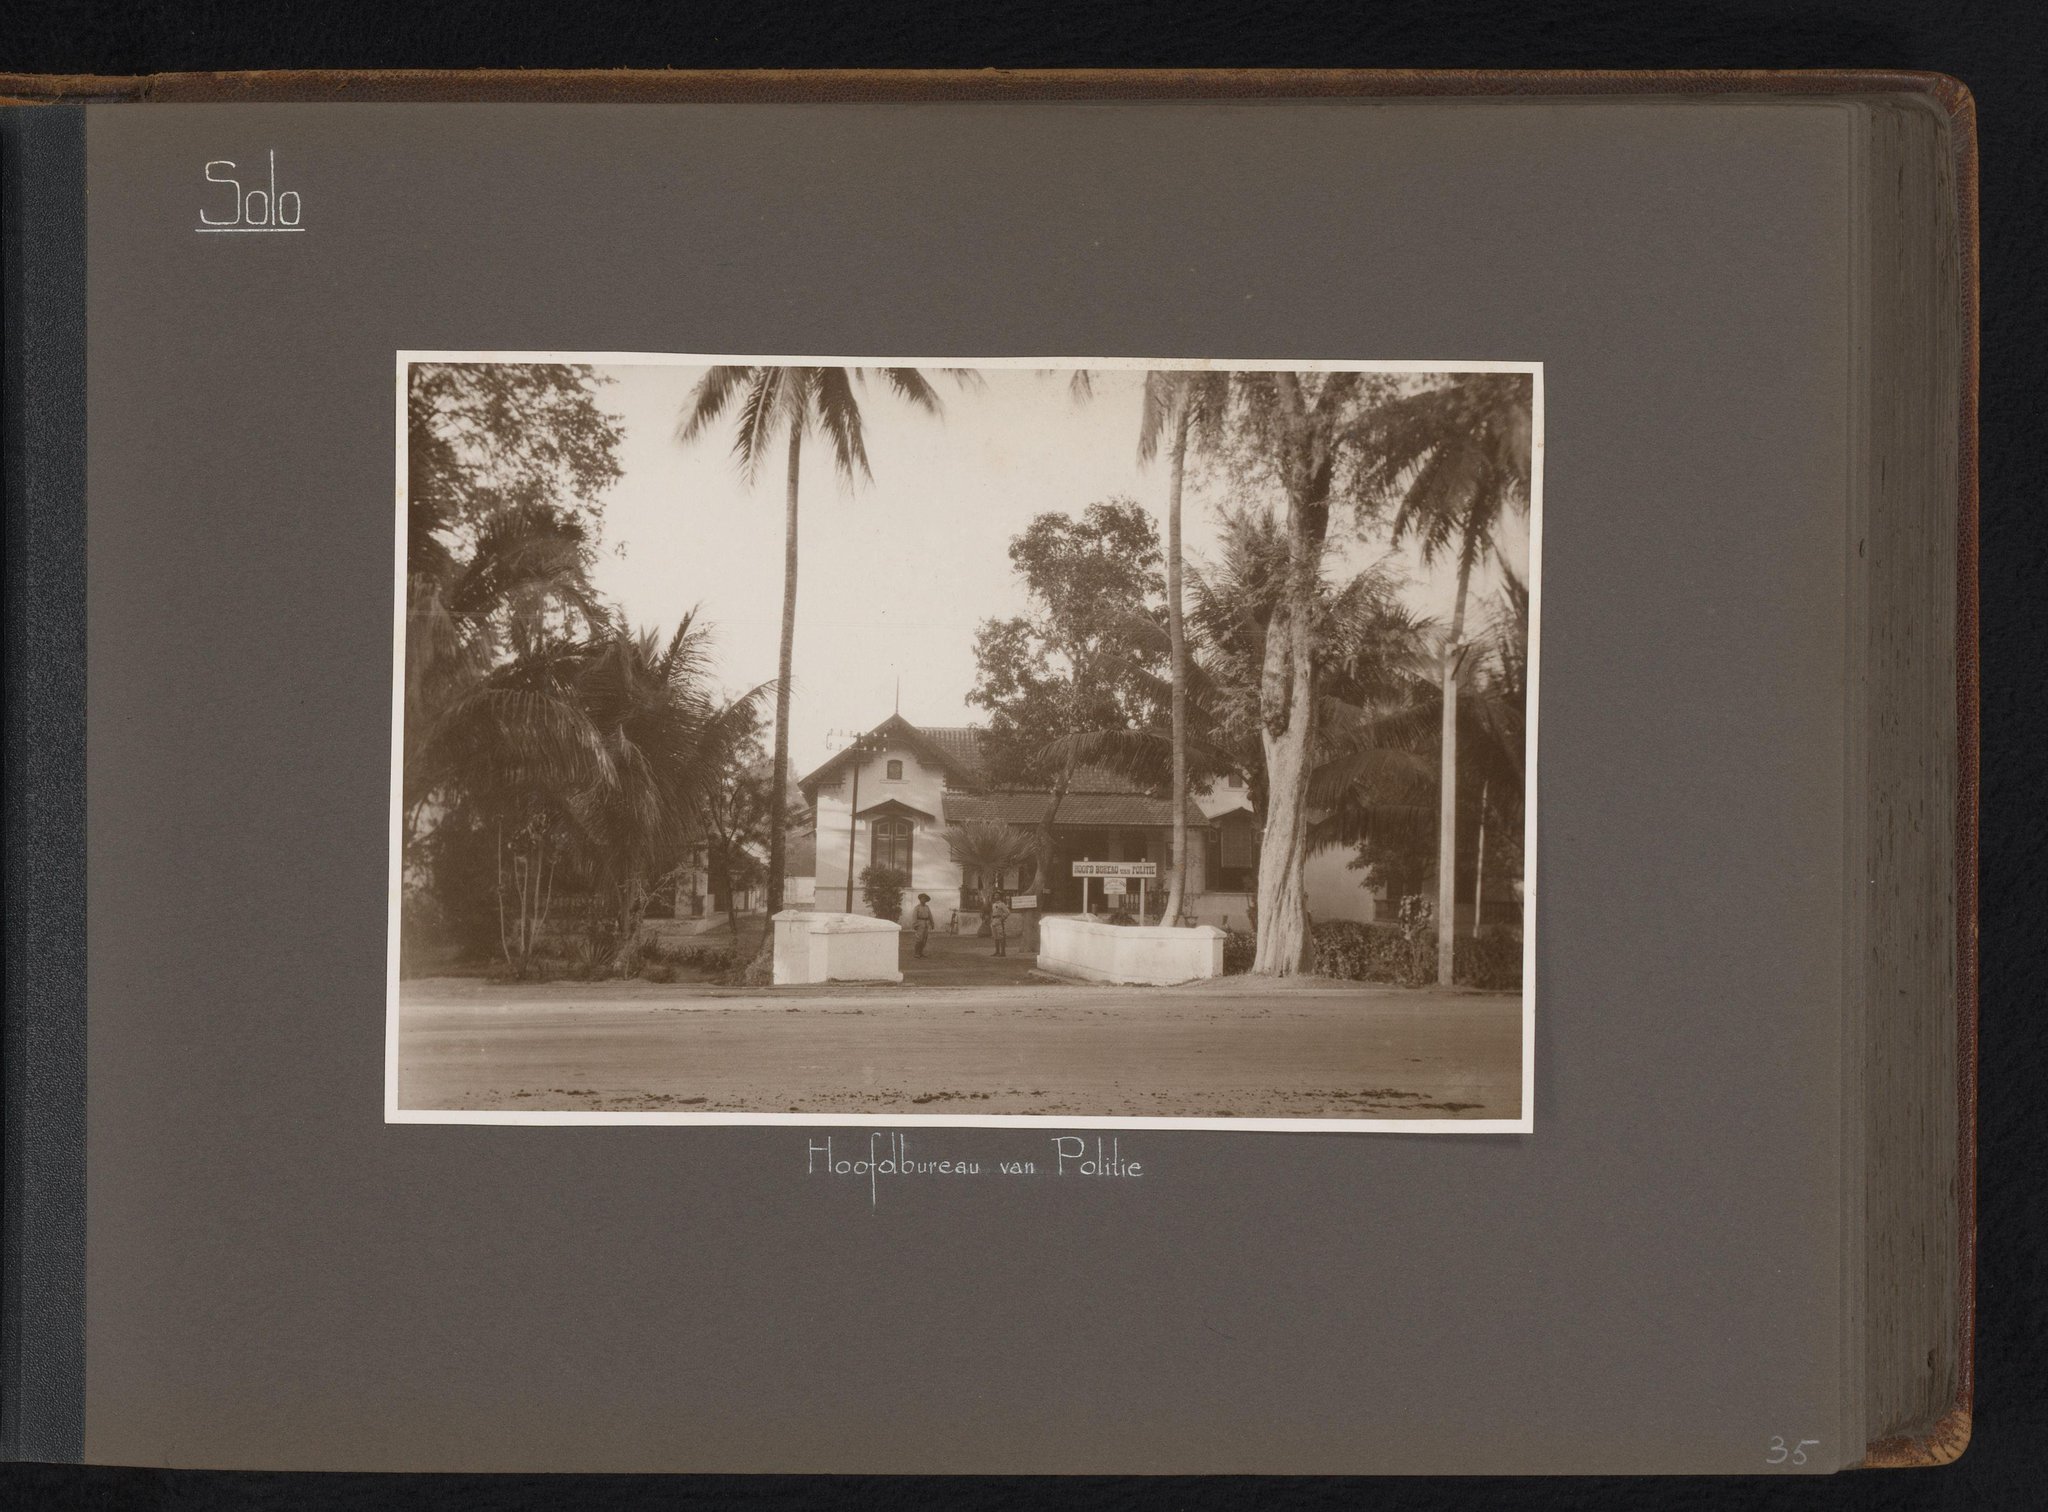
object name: photograph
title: Solo / Hoofdbureau van Politie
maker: Anonymous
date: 1925-1931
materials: cardboard, photographic support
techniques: gelatin silver print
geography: solo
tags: dutch east indies, the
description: Albumblad met één foto: het hoofdbureau van politie te Solo. Onderdeel van het fotoalbum aangeboden aan S. Koster door de Vereeniging van Hoogere Politie Ambtenaren in Nederlandsch-Indië in 1931.